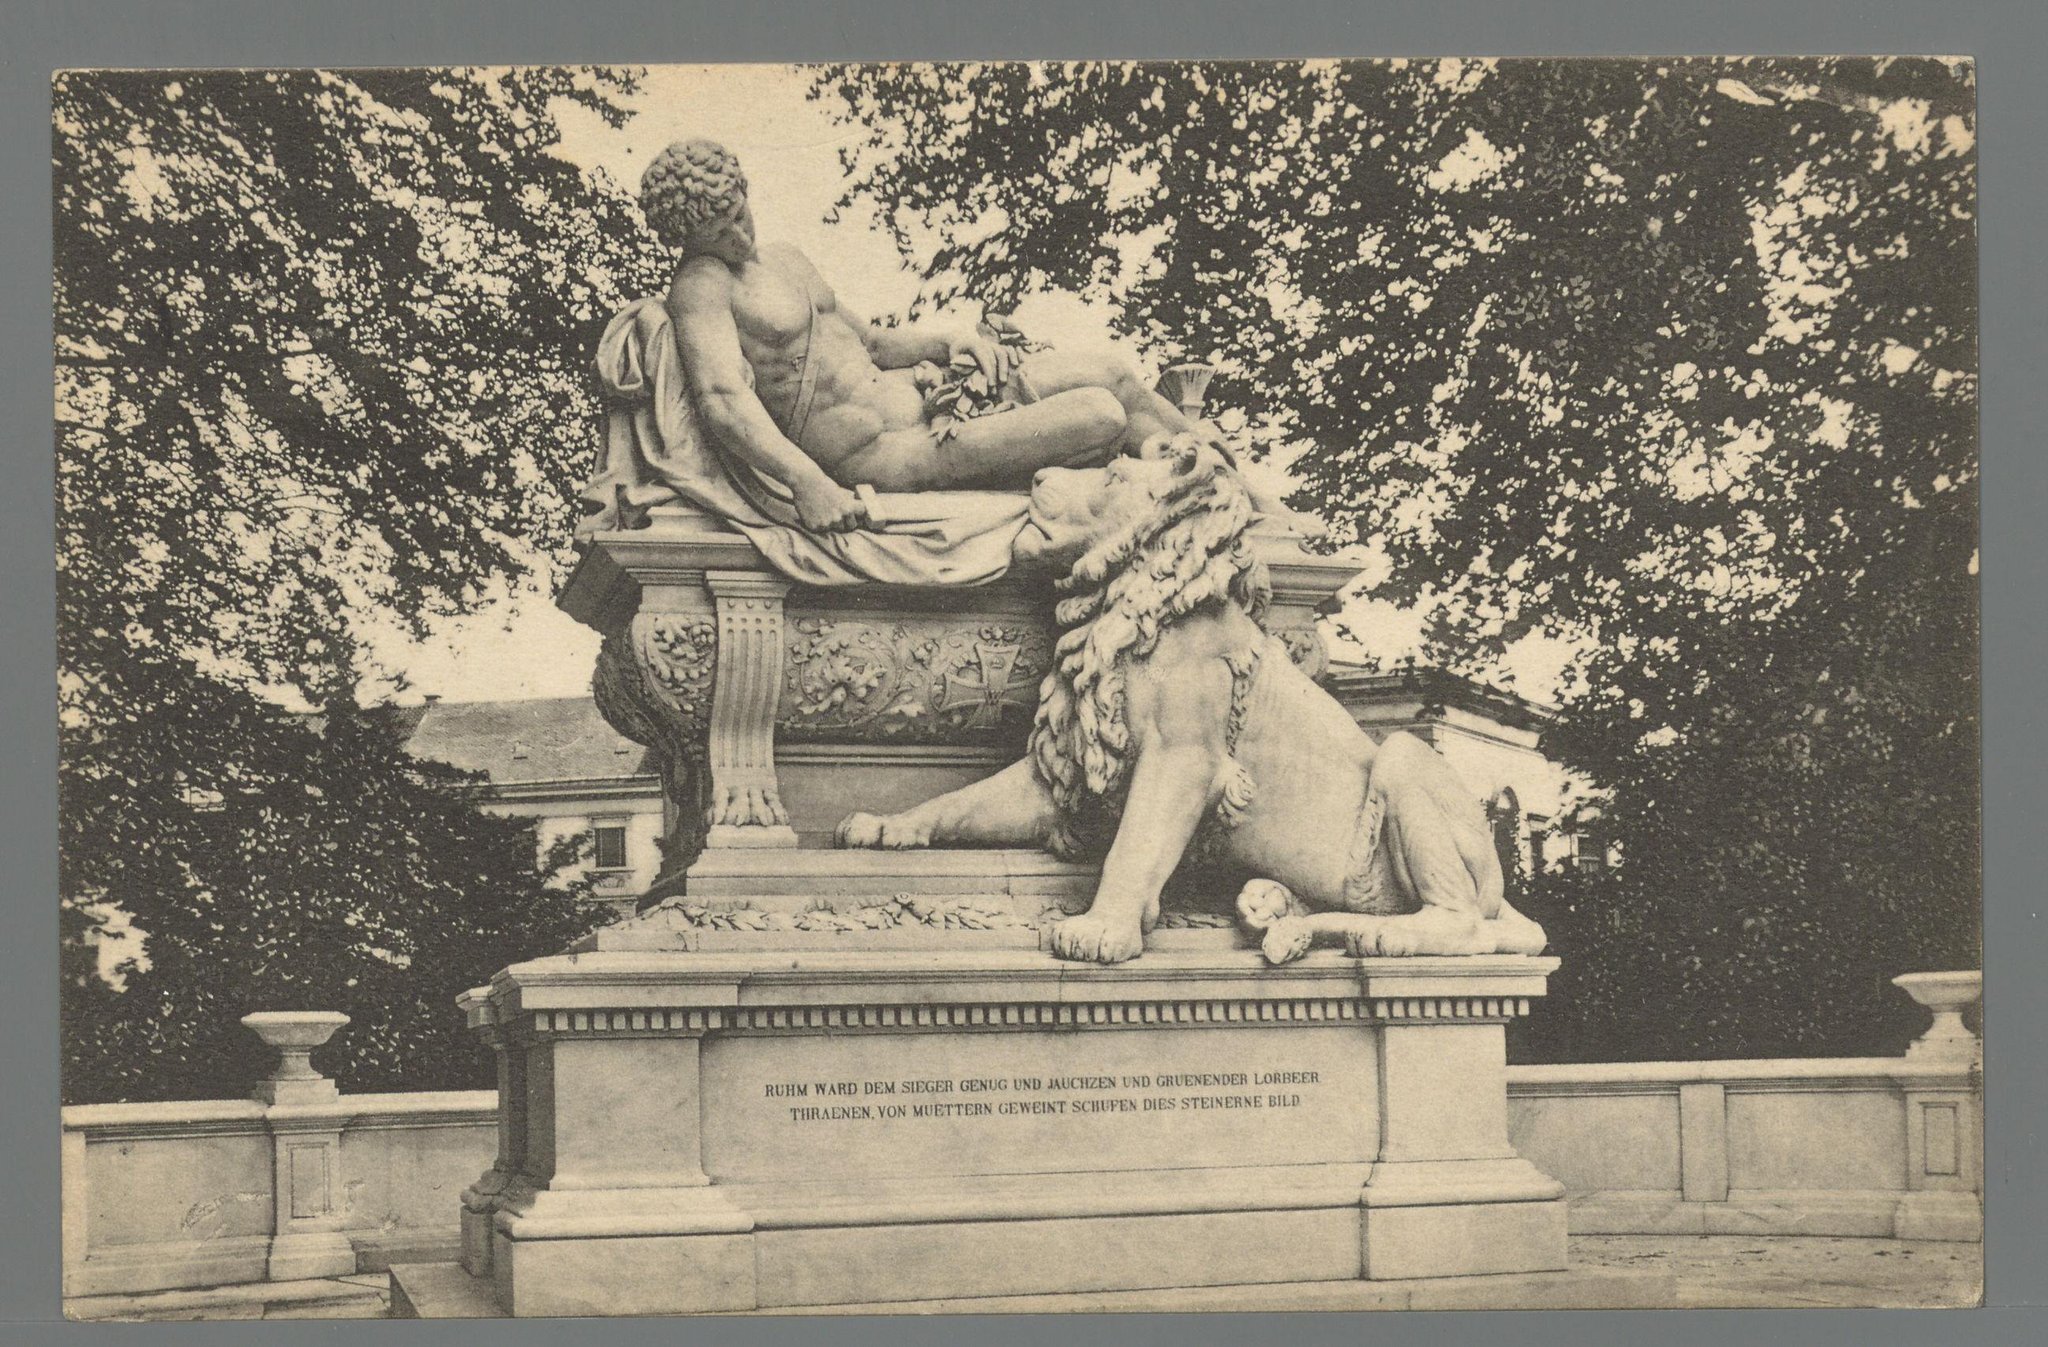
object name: photomechanical print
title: Düsseldorf. Kriegerdenkmal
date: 1905-1911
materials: cardboard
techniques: photograph, writing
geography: dusseldorf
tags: park, avenue, boulevard, promenade, esplanade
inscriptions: postage stamp